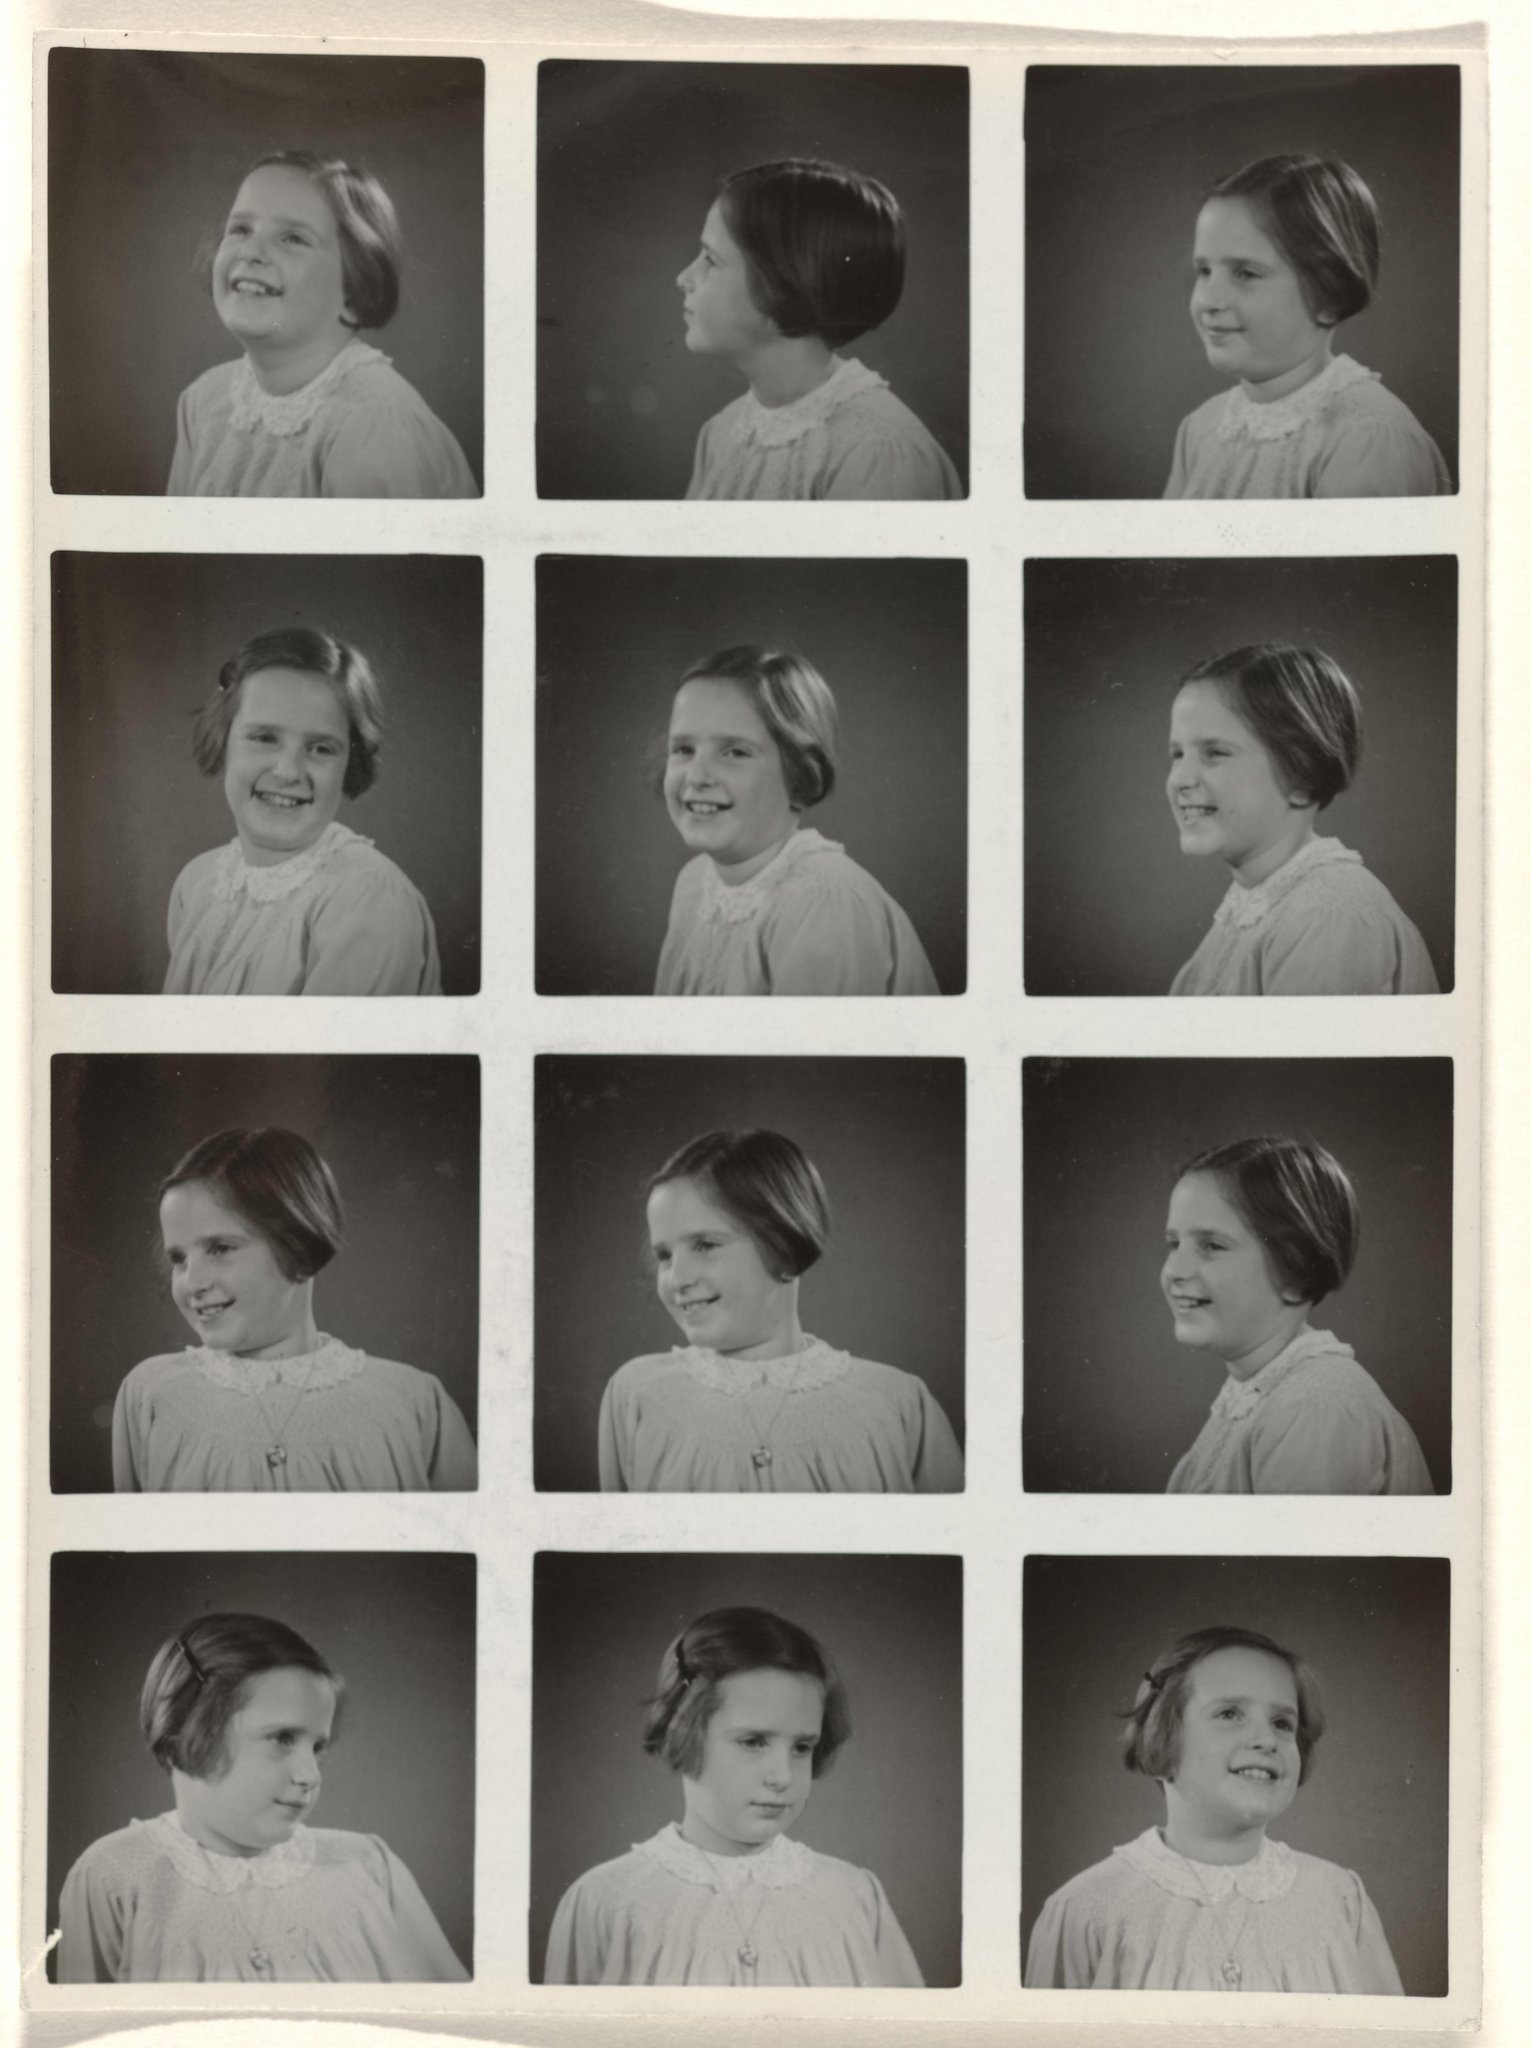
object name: photograph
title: Photographs from the Estate of Isabel Wachenheimer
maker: Anonymous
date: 1931-1937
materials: photographic support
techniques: gelatin silver print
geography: stuttgart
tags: isabel wachenheimer-elon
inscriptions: company name: ‘Polyfoto nummer Stuttgart-w. Marienstrasse 2.’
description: In 1928 a daughter, Isabel, was born to Eugen and Else Wachenheimer. In 1934 they posed before the family home in Stuttgart on Isabel’s first day of school. The photograph at the lower right was taken almost ten years later (1943) in the Westerbork transit camp. Isabel had been rounded up in Amsterdam five months earlier. The family was first sent to Theresienstadt and then on to Auschwitz-Birkenau, where Eugen and Else were gassed. Isabel was condemned to forced labour.